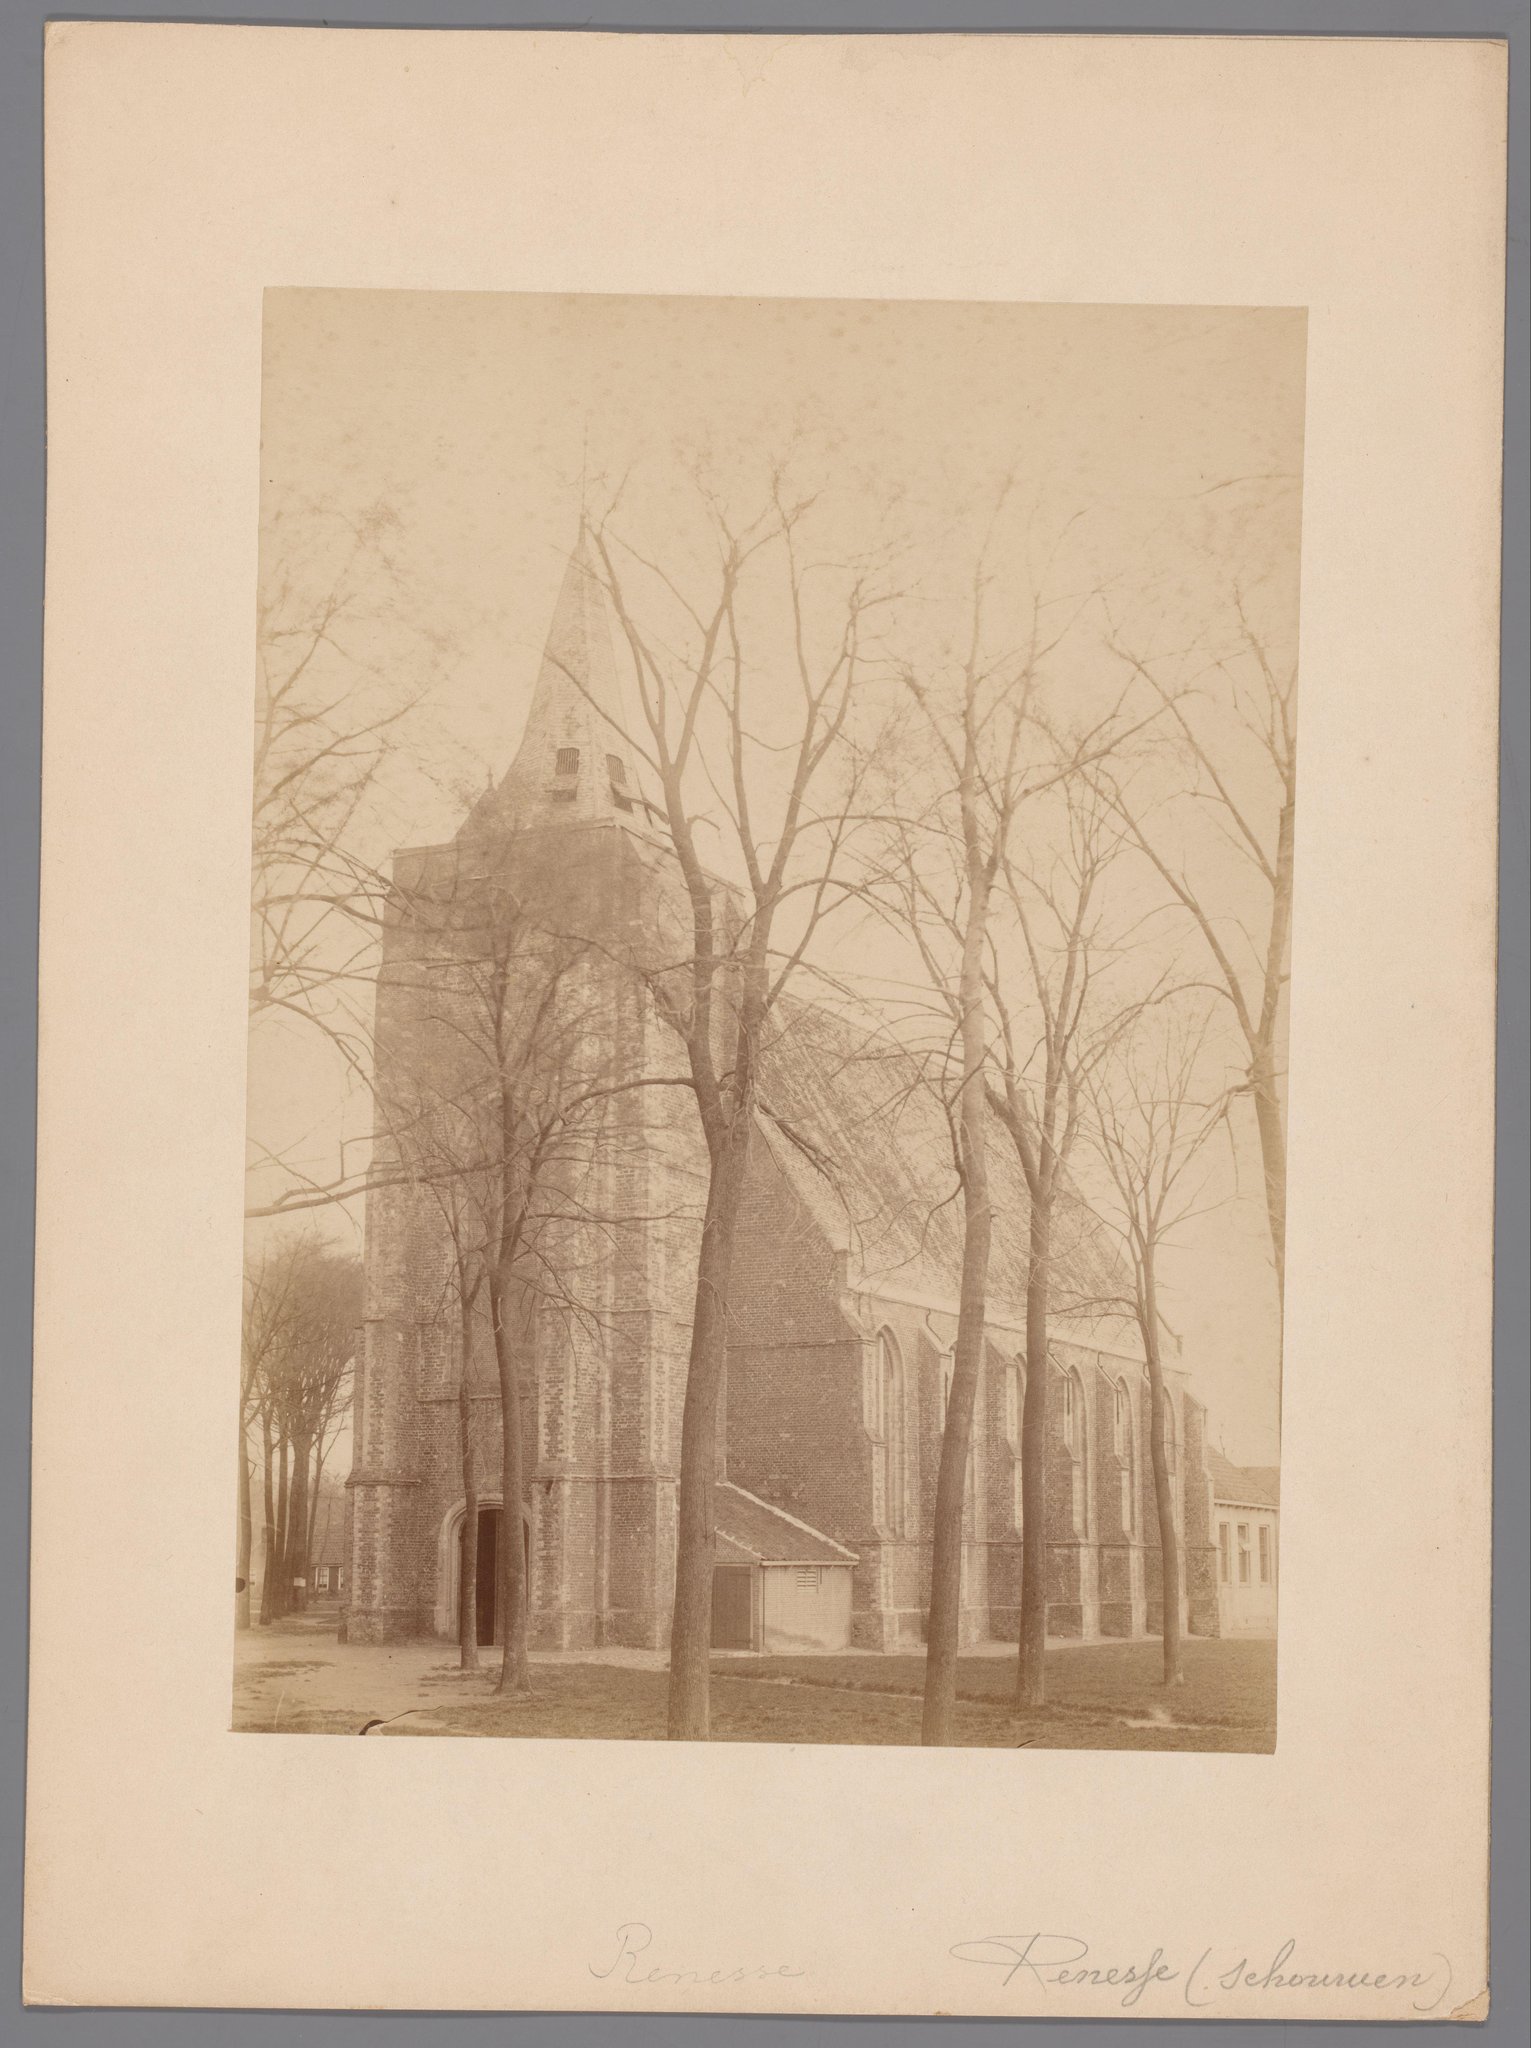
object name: photograph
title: Gezicht op de Jacobuskerk te Renesse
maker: anoniem (monumentenzorg)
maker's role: fotograaf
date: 1893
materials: cardboard, photographic support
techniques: albumen print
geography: renesse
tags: church (exterior)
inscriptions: annotation: ‘Renesse op het eiland Schouwen/ Zeeland/ Zuid-Westzijde de kerk en den toren (st. Jacobuskerk)/ Maart 1893’, annotation: ‘Renesse (Schouwen)’